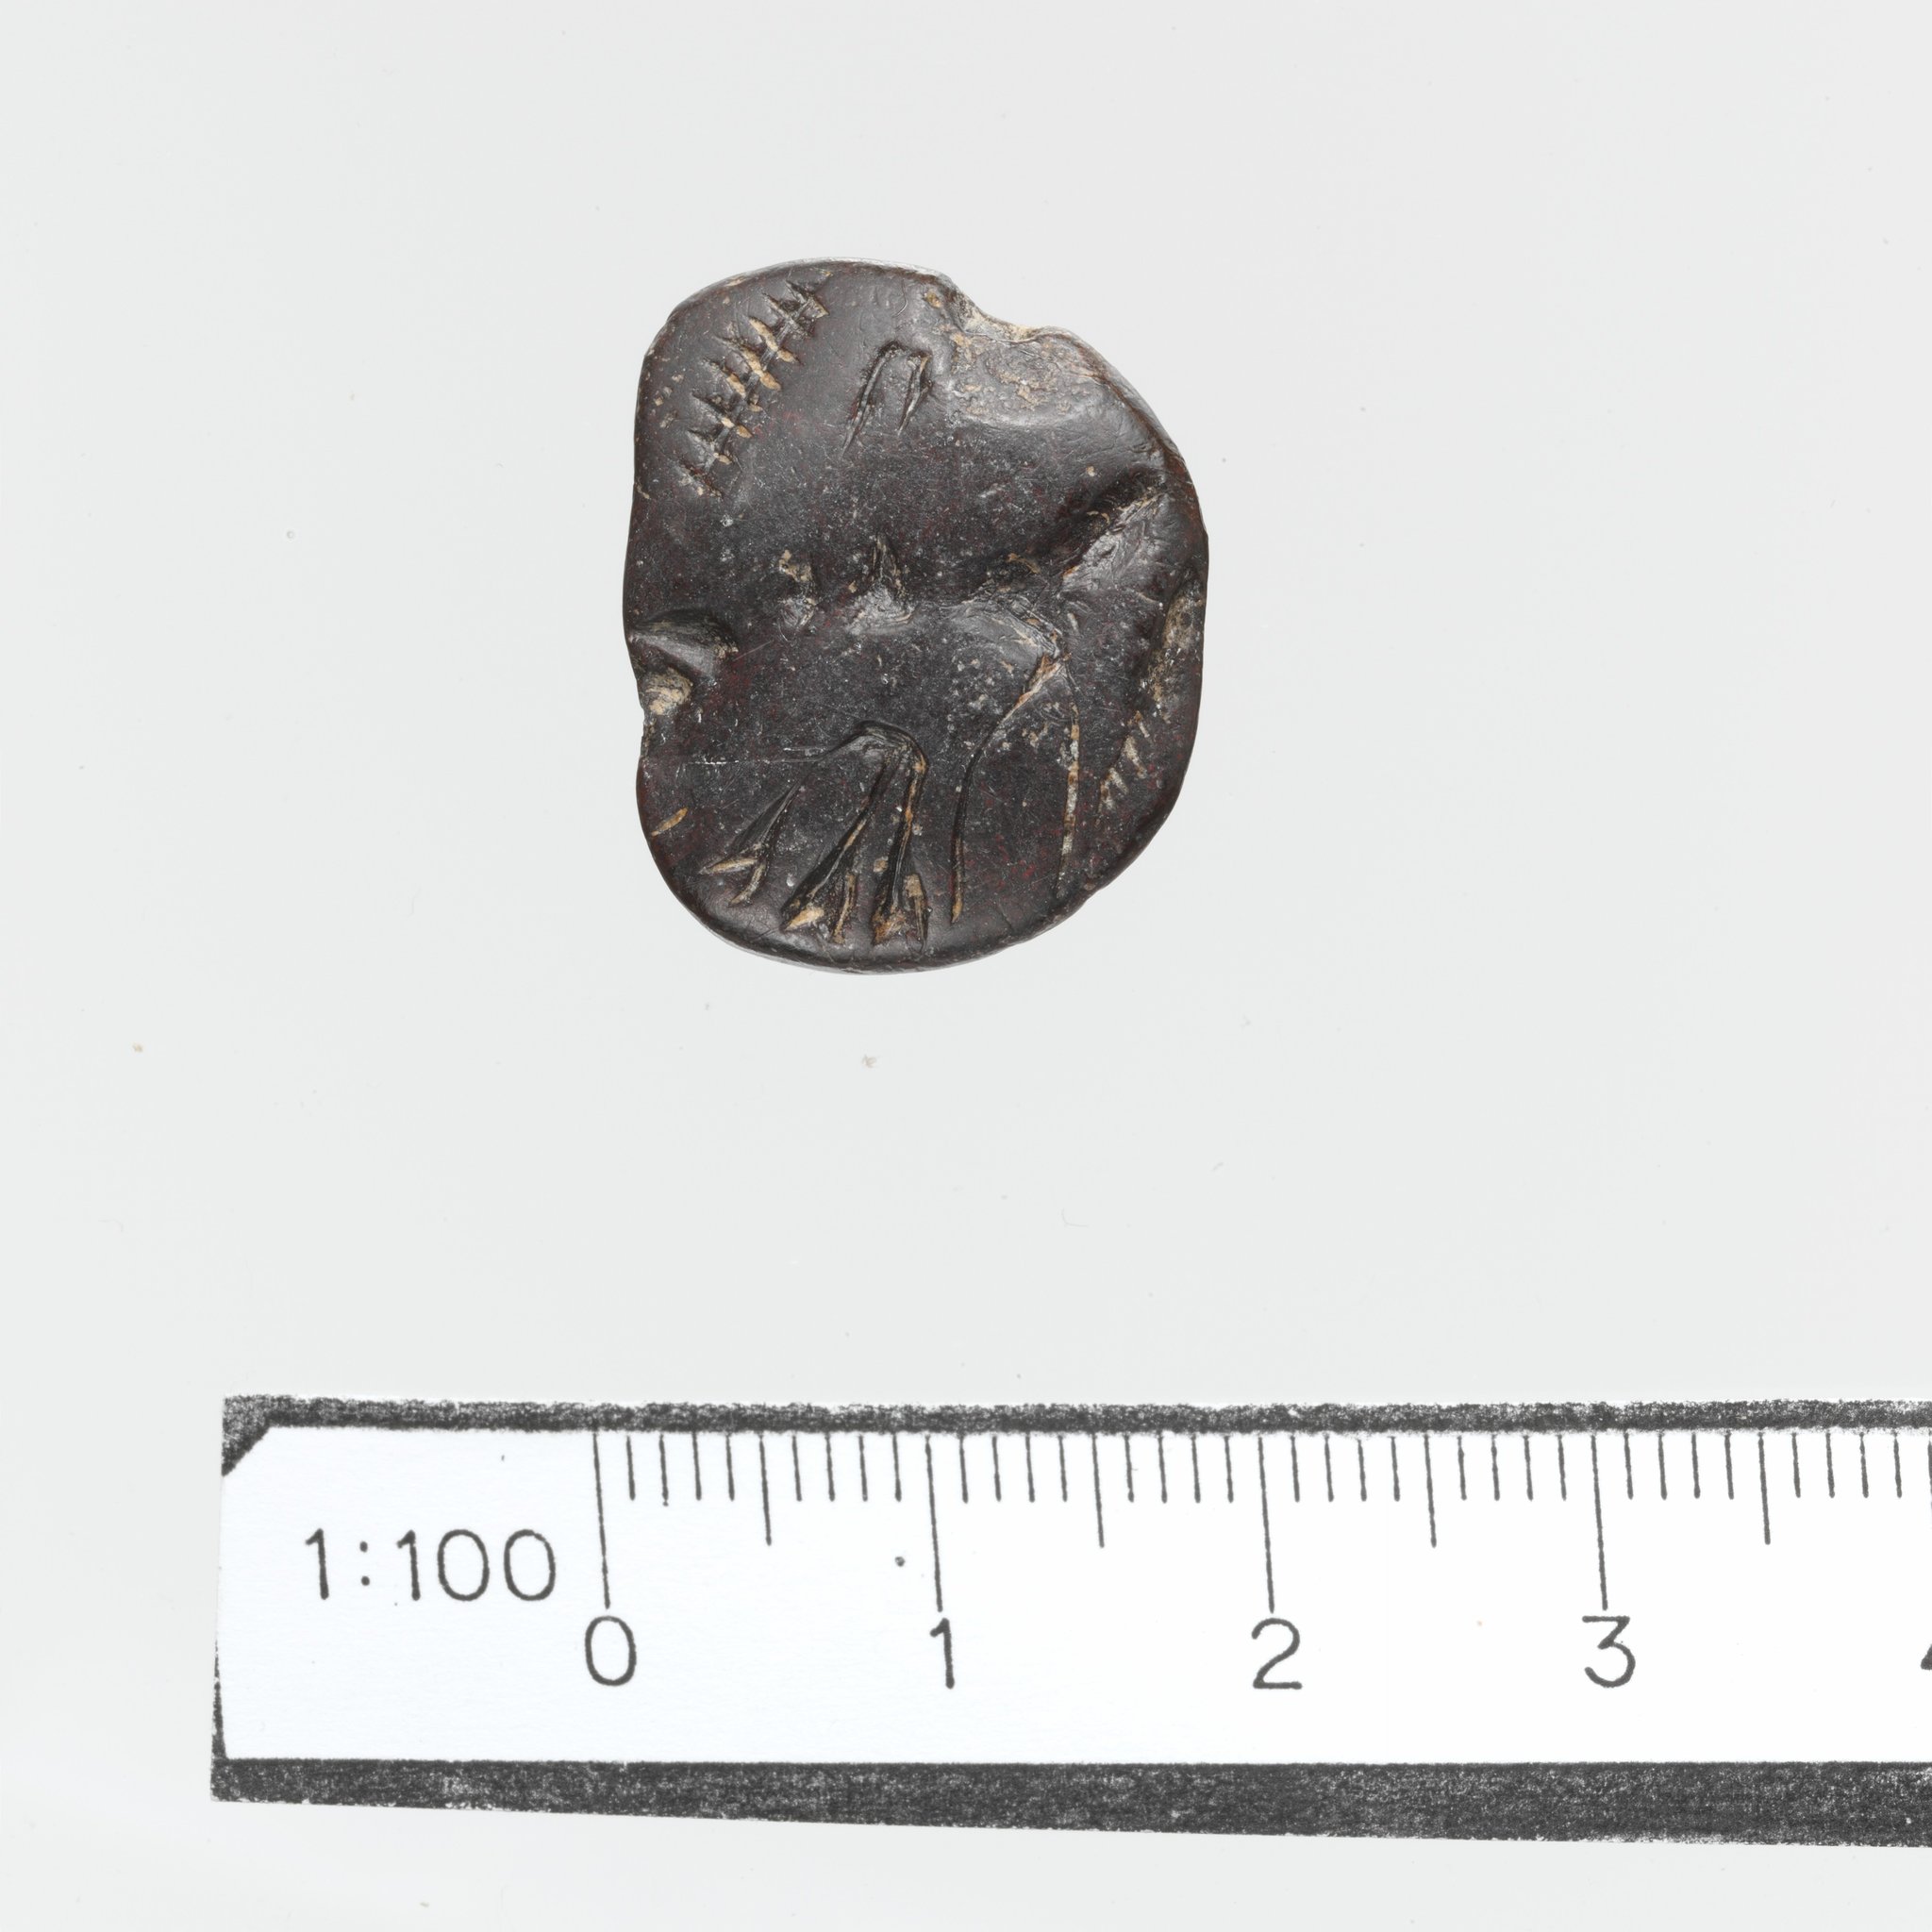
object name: seal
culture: minoan, crete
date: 2000-1450 BCE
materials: jasper